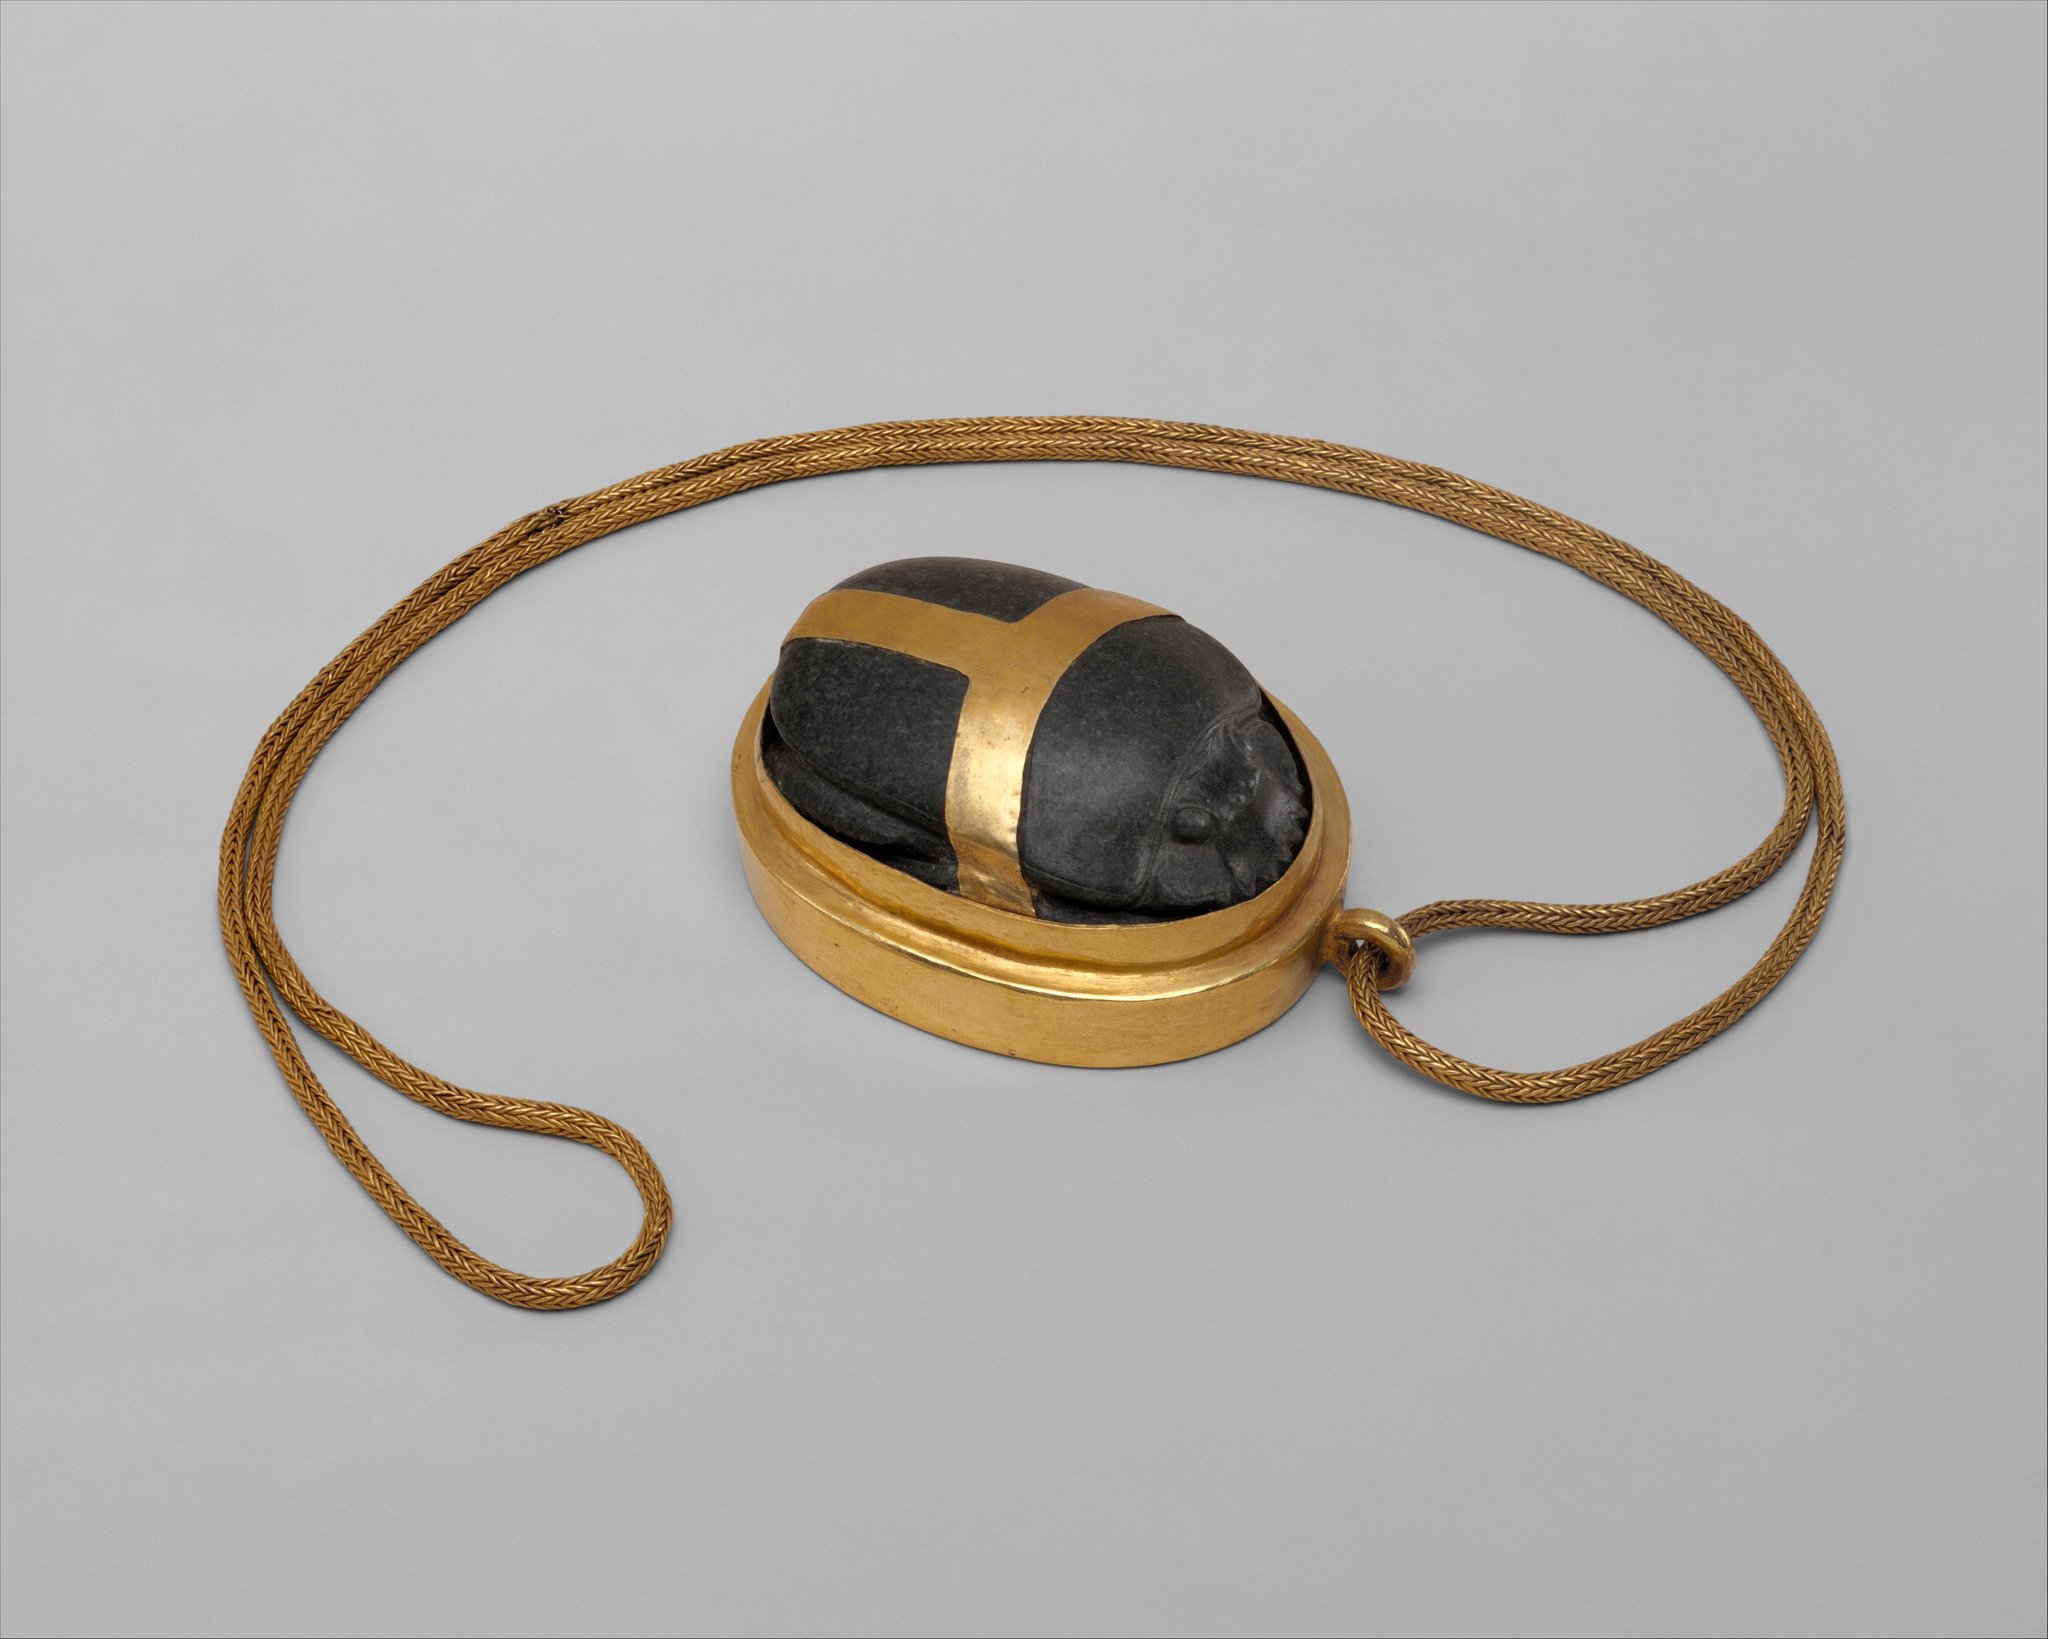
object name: heart scarab, hatnefer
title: Heart Scarab of Hatnefer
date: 1492-1473 BCE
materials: gold, stone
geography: egypt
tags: hieroglyphs,scarabs